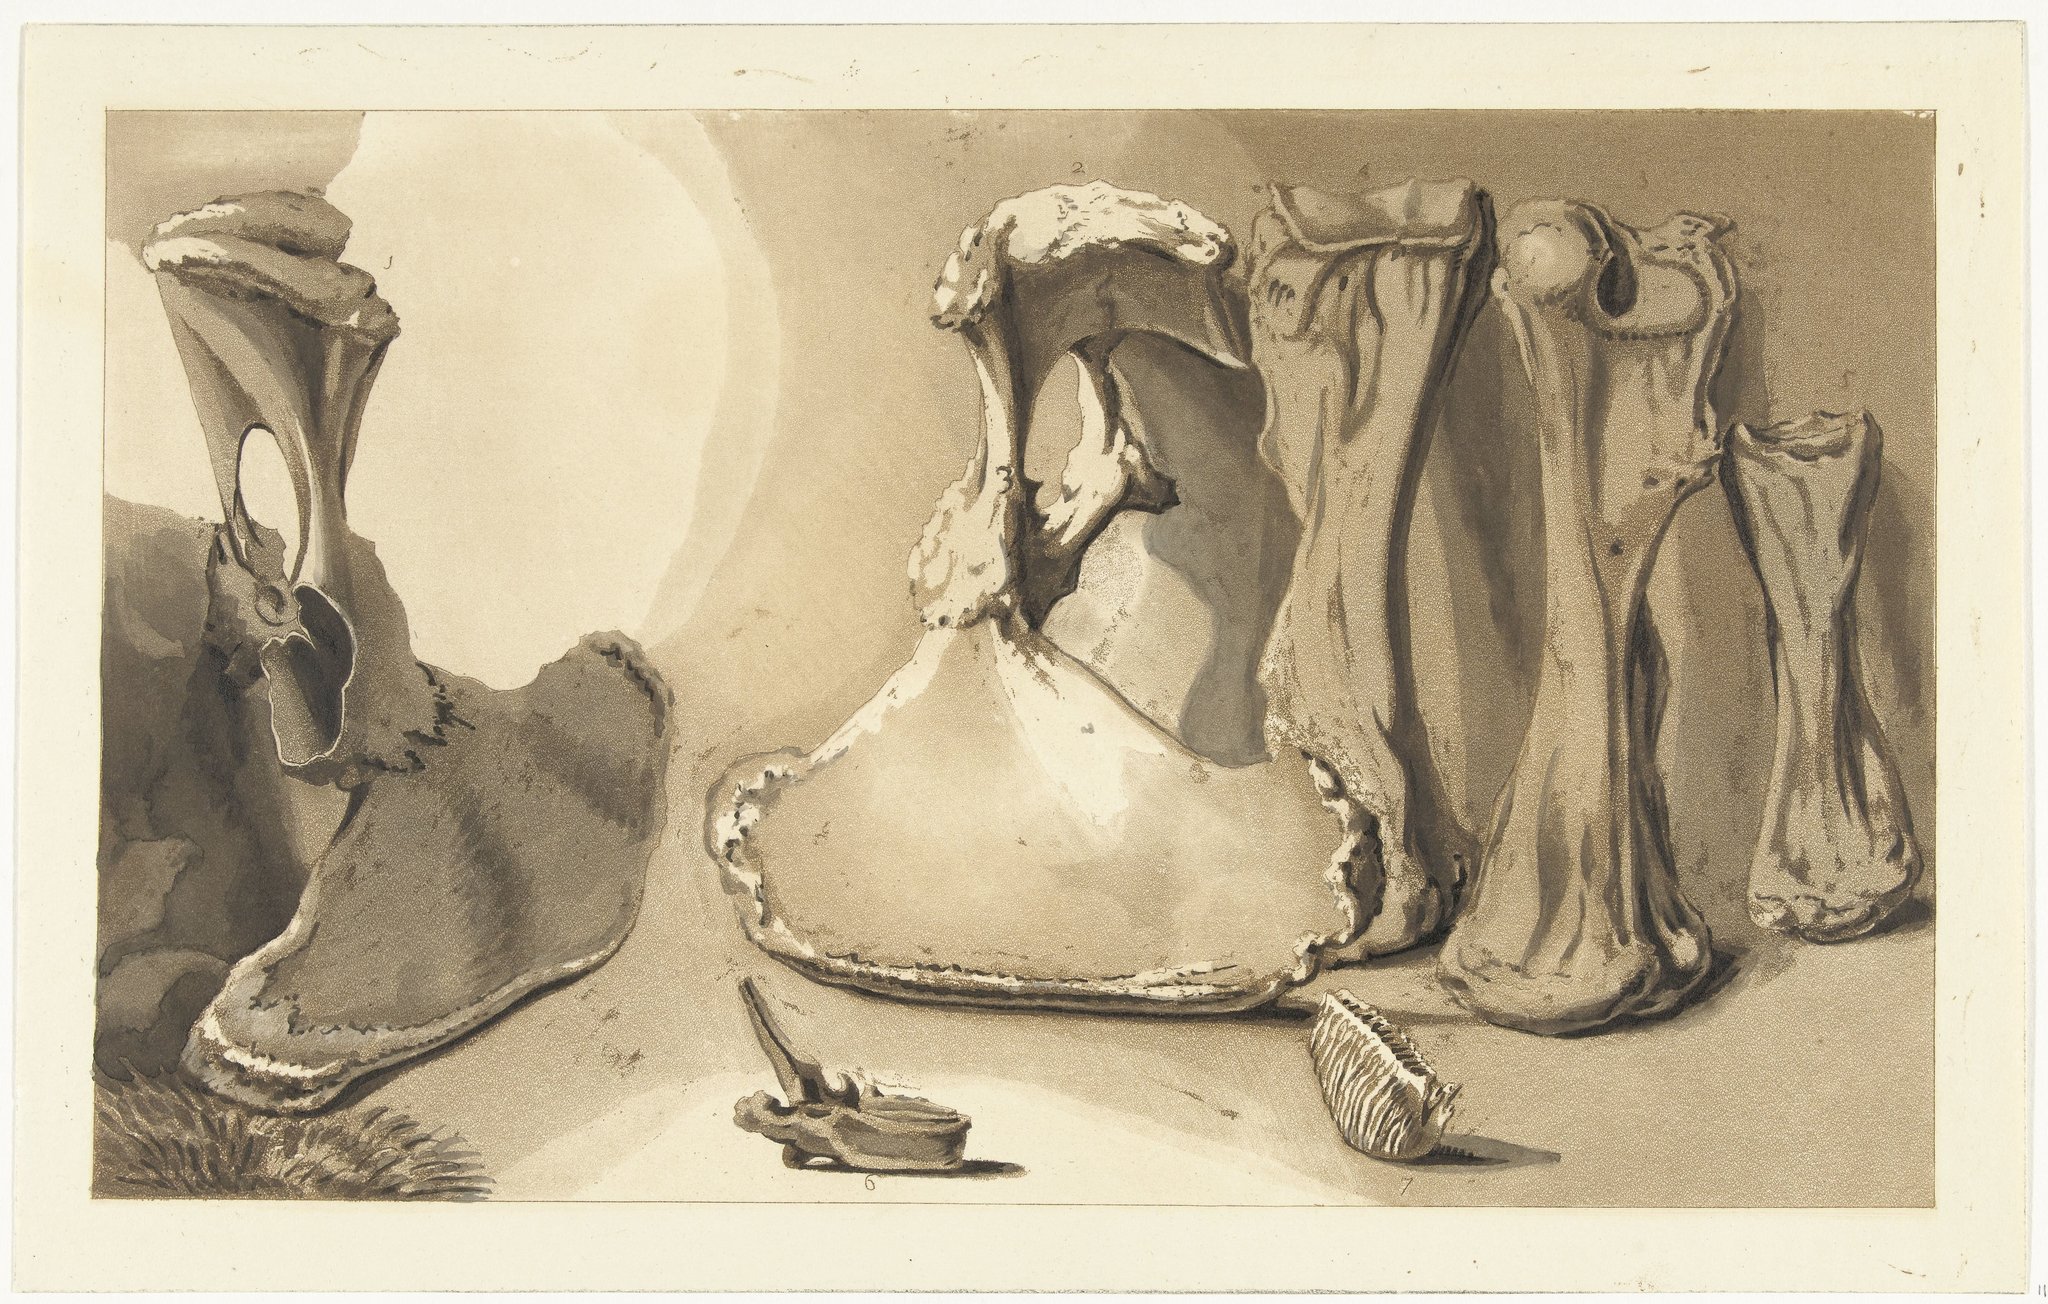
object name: book illustration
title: Aangespoelde beenderen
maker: anthonie van den bos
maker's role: draughtsman, print maker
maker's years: 1763-1838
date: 1809-1810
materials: paper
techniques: aquatint, brush, etching, hand coloring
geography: netherlands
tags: bones in general (human body), gelderland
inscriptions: collector's mark: Lugt 2228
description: Plaat gemaakt voor: H. Ewijk, Platen en kaarten behorende tot het geschiedkundig verslag der dijkbreuken en overstroomingen, langs de rivieren in het Koningrijk Holland, voorgevallen in louwmaand MDCCCIX. Amsterdam, J. Allart en J. Ruys, 1809.